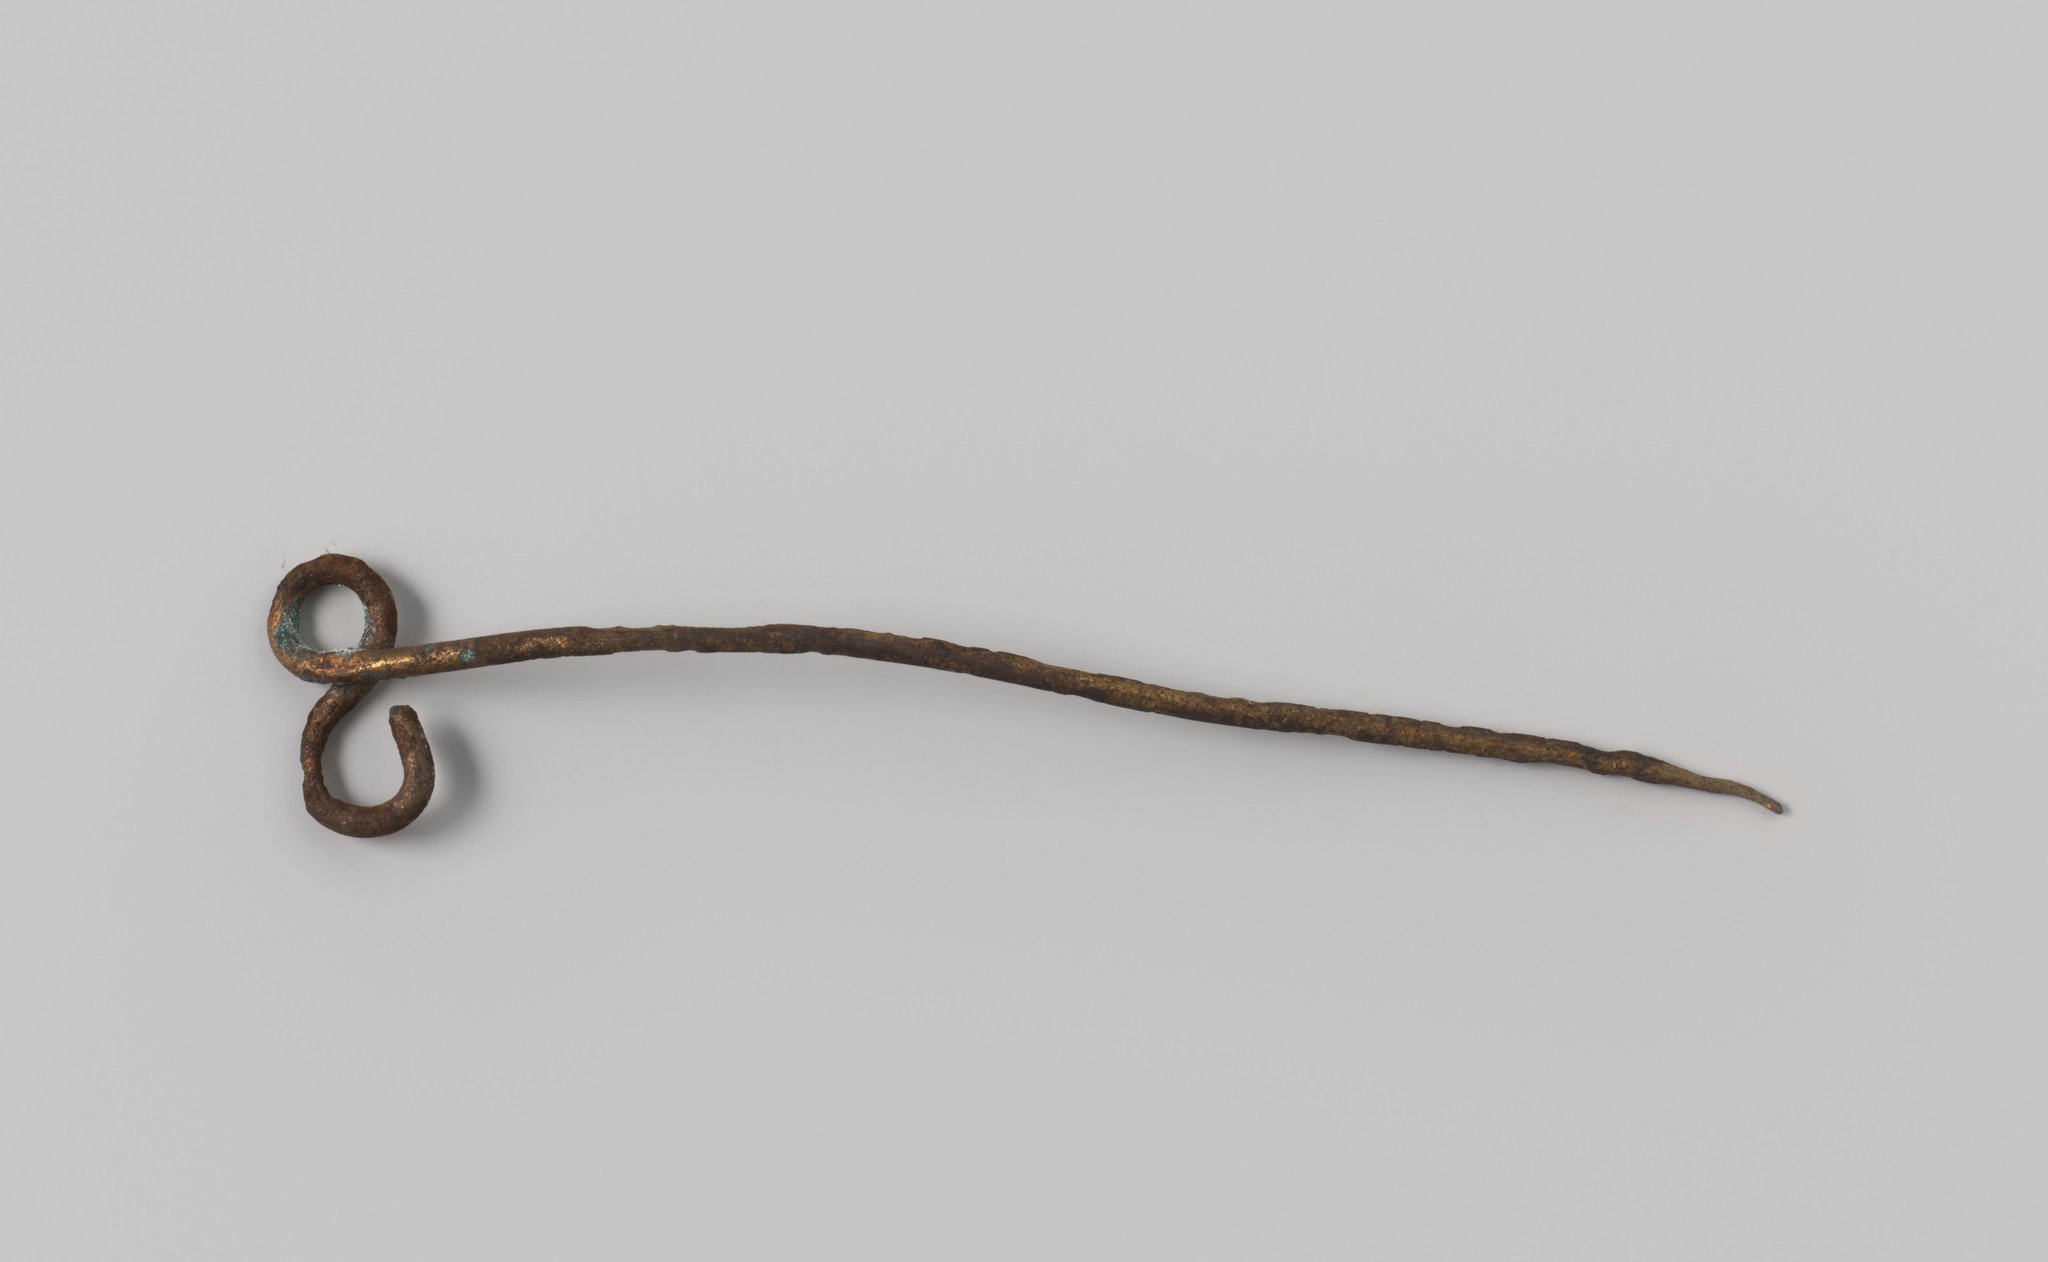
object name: priming wire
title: Laadpriem uit het wrak van de Oost-Indiëvaarder Hollandia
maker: Anonymous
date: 1700-1743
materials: copper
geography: netherlands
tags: verenigde oostindische compagnie, hollandia (schip), annet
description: Priming wire; fragm, upper end, shaft eroded, id. NG 1975-17H374.